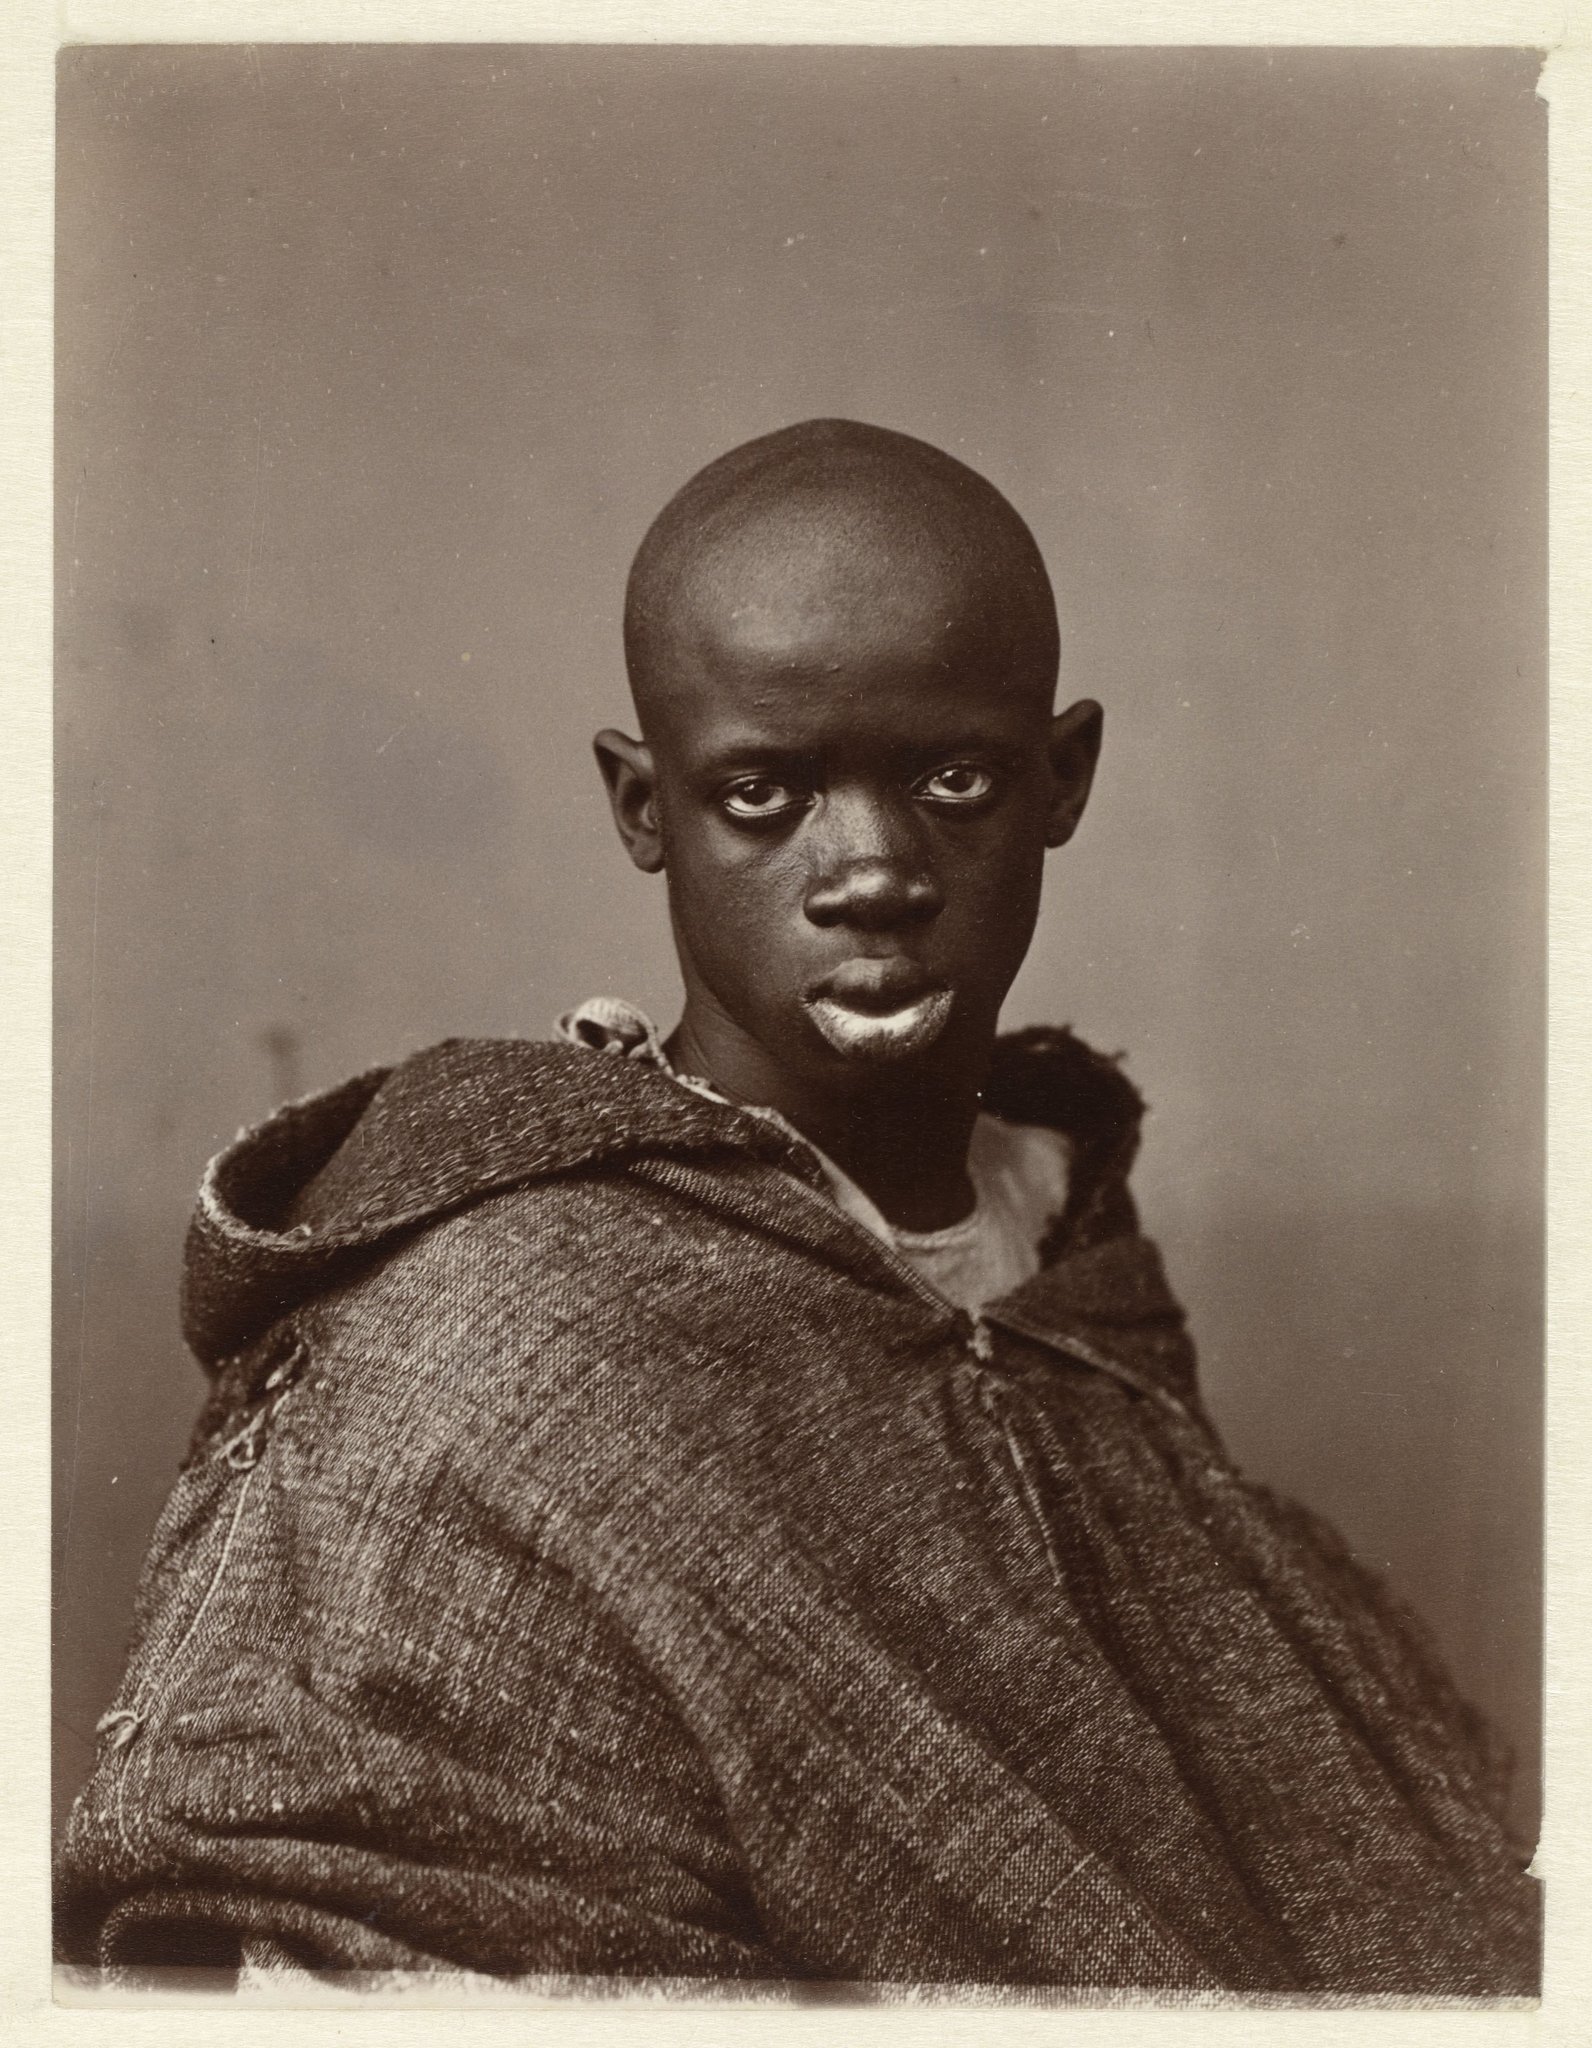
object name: photograph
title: Portraits of a Young Man from North Africa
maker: antonio cavilla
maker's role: fotograaf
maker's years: 1867-1908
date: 1884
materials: paper, photographic support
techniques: albumen print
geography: north africa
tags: historical persons - bb - woman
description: In the 19th century there was a demand for portraits of peoples of the regions travellers visited. Anthropologists and ethnographers used them for study purposes. The photograph at the left is unusual in that the sitter looks at us with such a penetrating gaze. Perhaps the photographer hung these portraits in his shop window in Algiers or Rabat to attract potential customers.